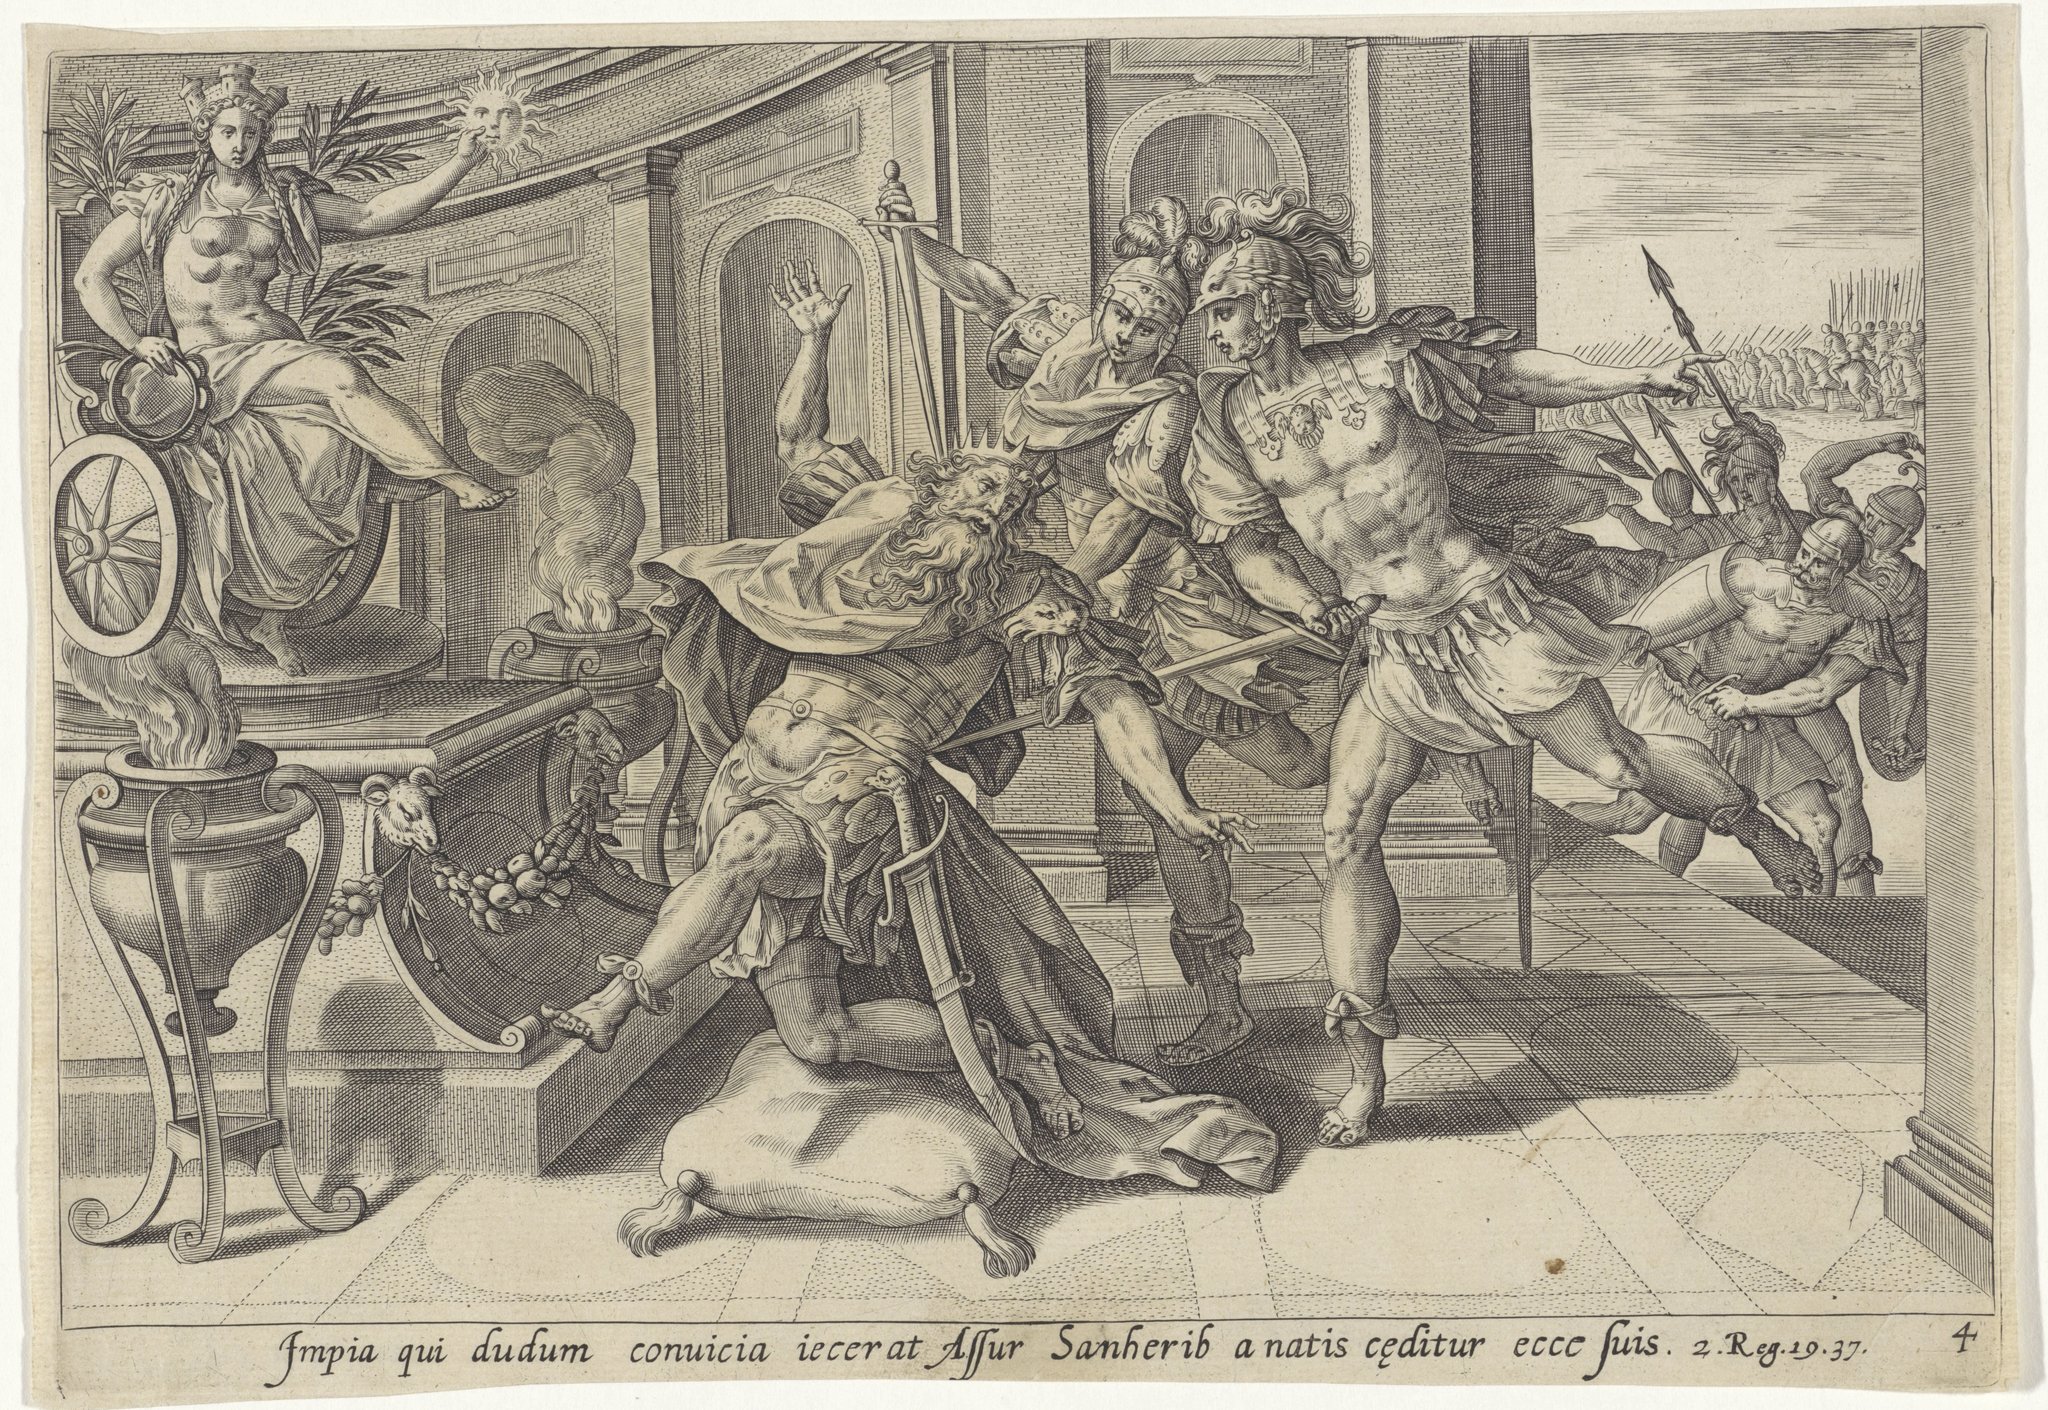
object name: print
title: Geschiedenis van Hizkia en Sanherib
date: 1585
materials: paper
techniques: engraving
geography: amsterdam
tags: when sennacherib is worshipping in the temple, two of his sons kill him with their swords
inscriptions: collector's mark: Lugt 2228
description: Prent gebruikt in: Theatrum biblicum : hoc est historiae sacrae veteris et novi testamenti tabulis aeneis expressae. Opus praesentatissimorum huius ac superioris seculi pictorum atque sculptorum, summo studio conquisitum et in lucem editum. Amsterdam: Claes Jansz. Visscher, 1643.